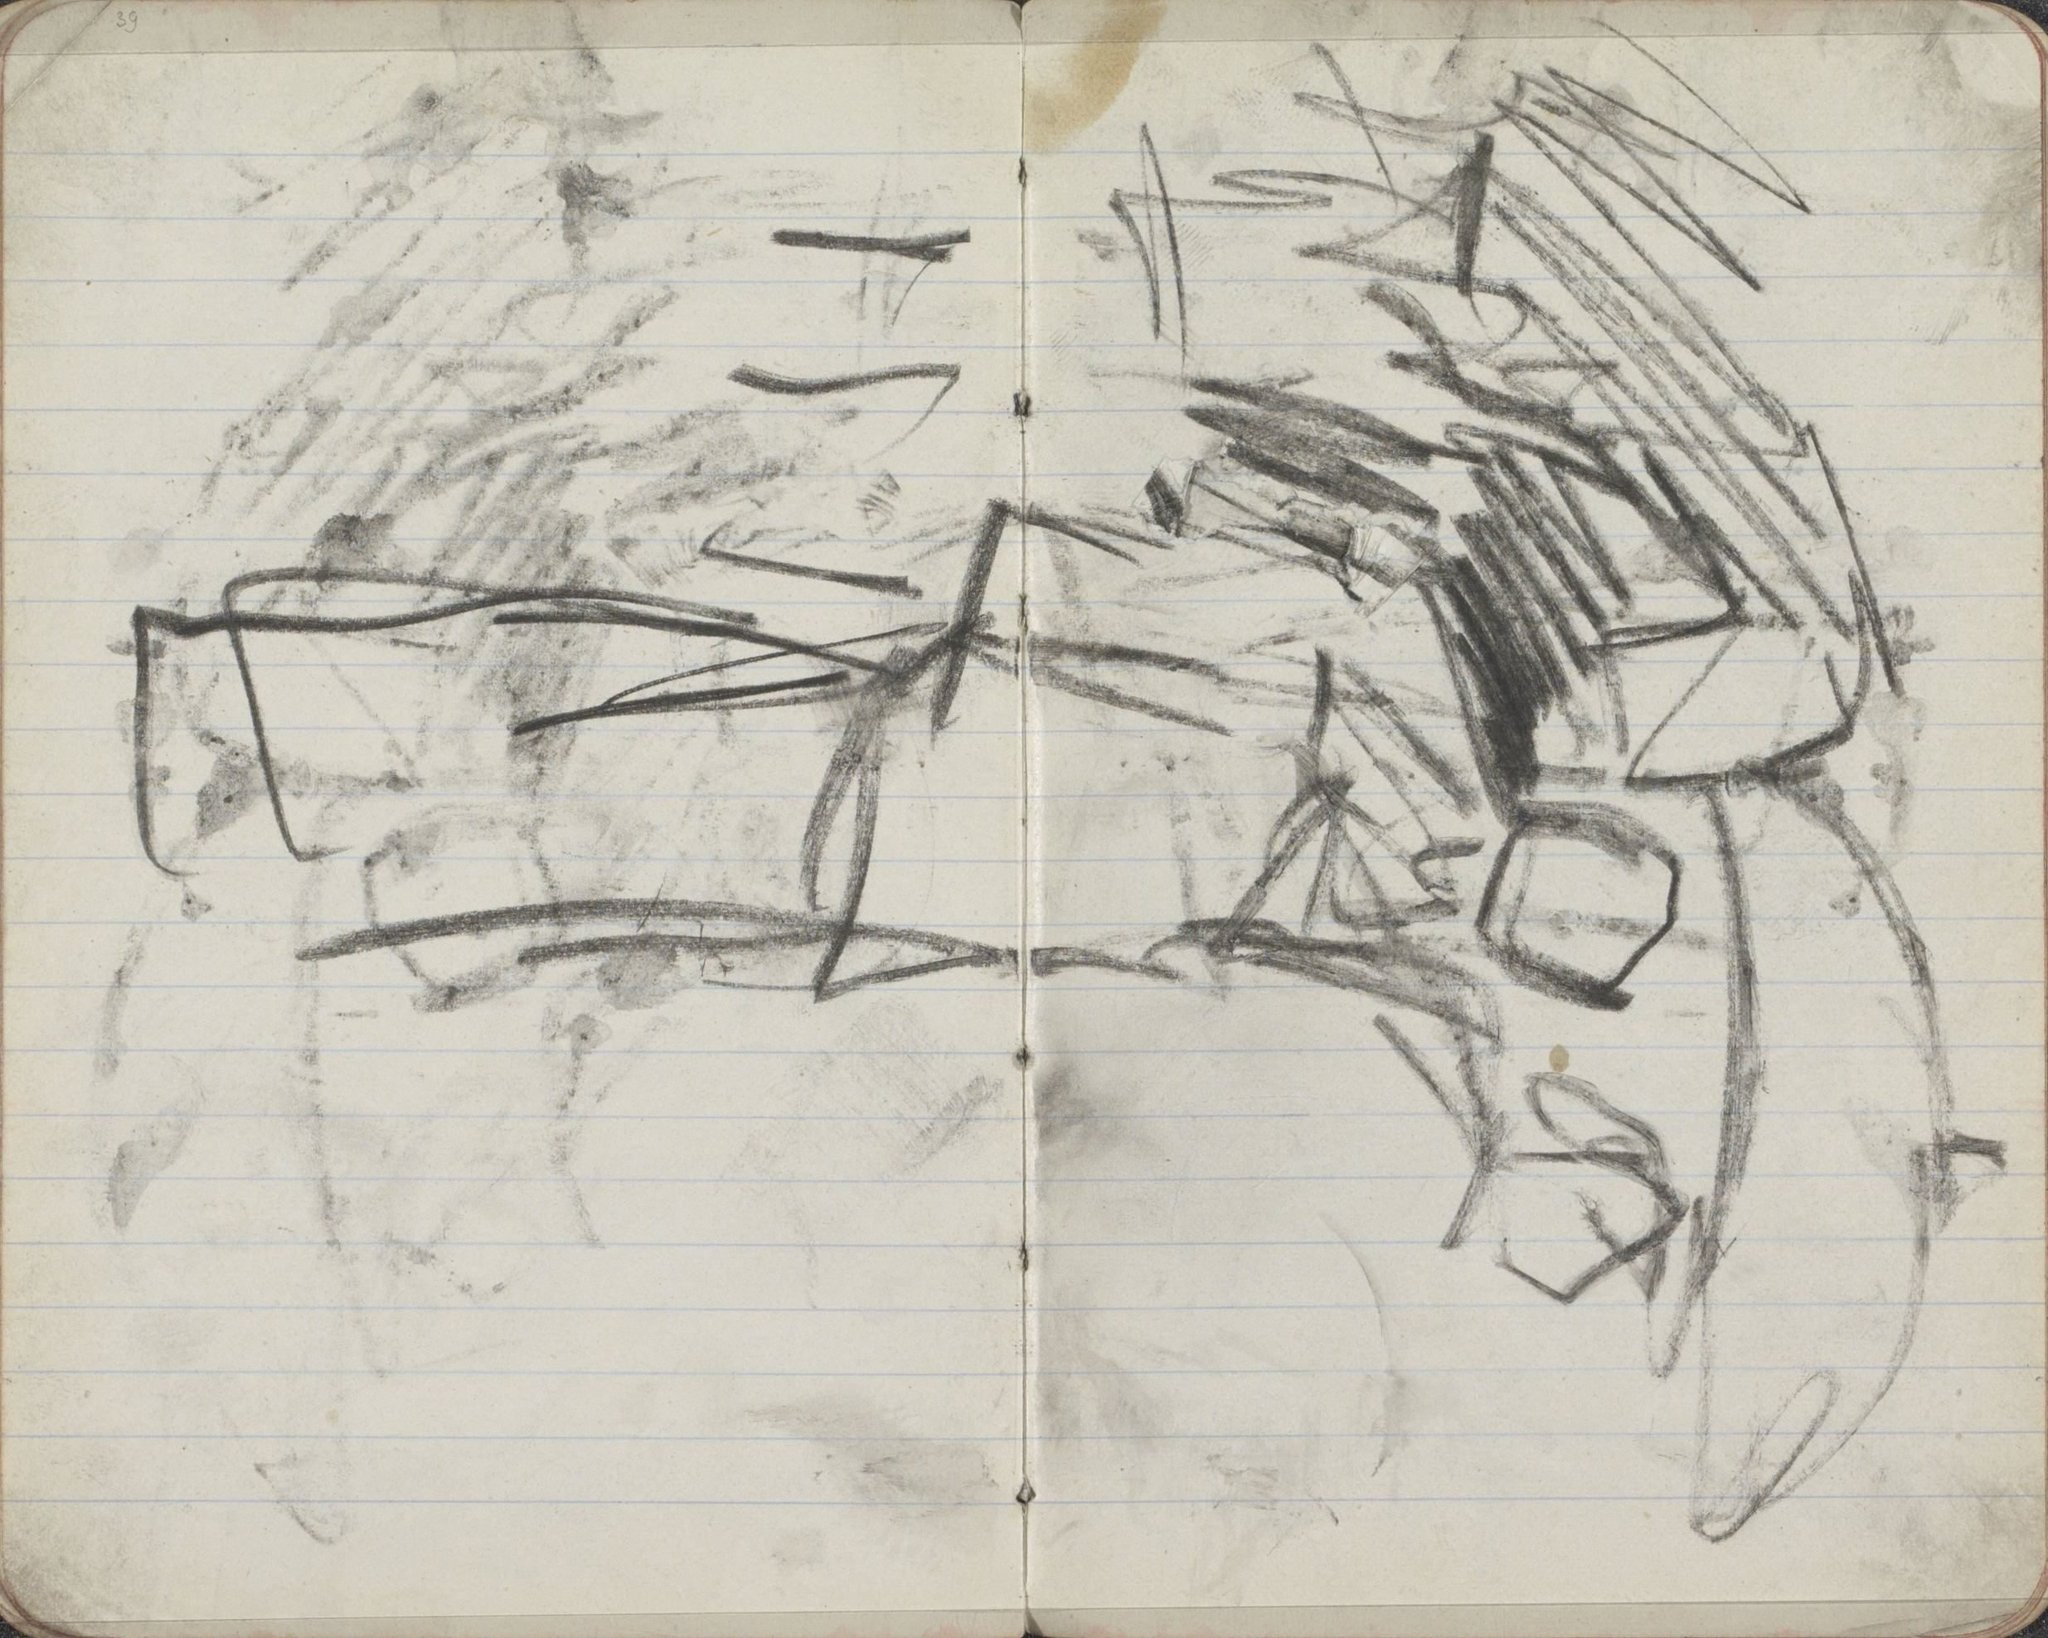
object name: sketchbook leaf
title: Figuren onder paraplu's, mogelijk op de Dam in Amsterdam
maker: george hendrik breitner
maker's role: draughtsman, painter, print maker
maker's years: 1857-1923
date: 1890-1900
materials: chalk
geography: amsterdam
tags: rain, square, place, circus, etc. (+ city(-scape) with figures, staffage)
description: Pagina 39 en pagina 40 uit een schetsboek met 33 bladen.